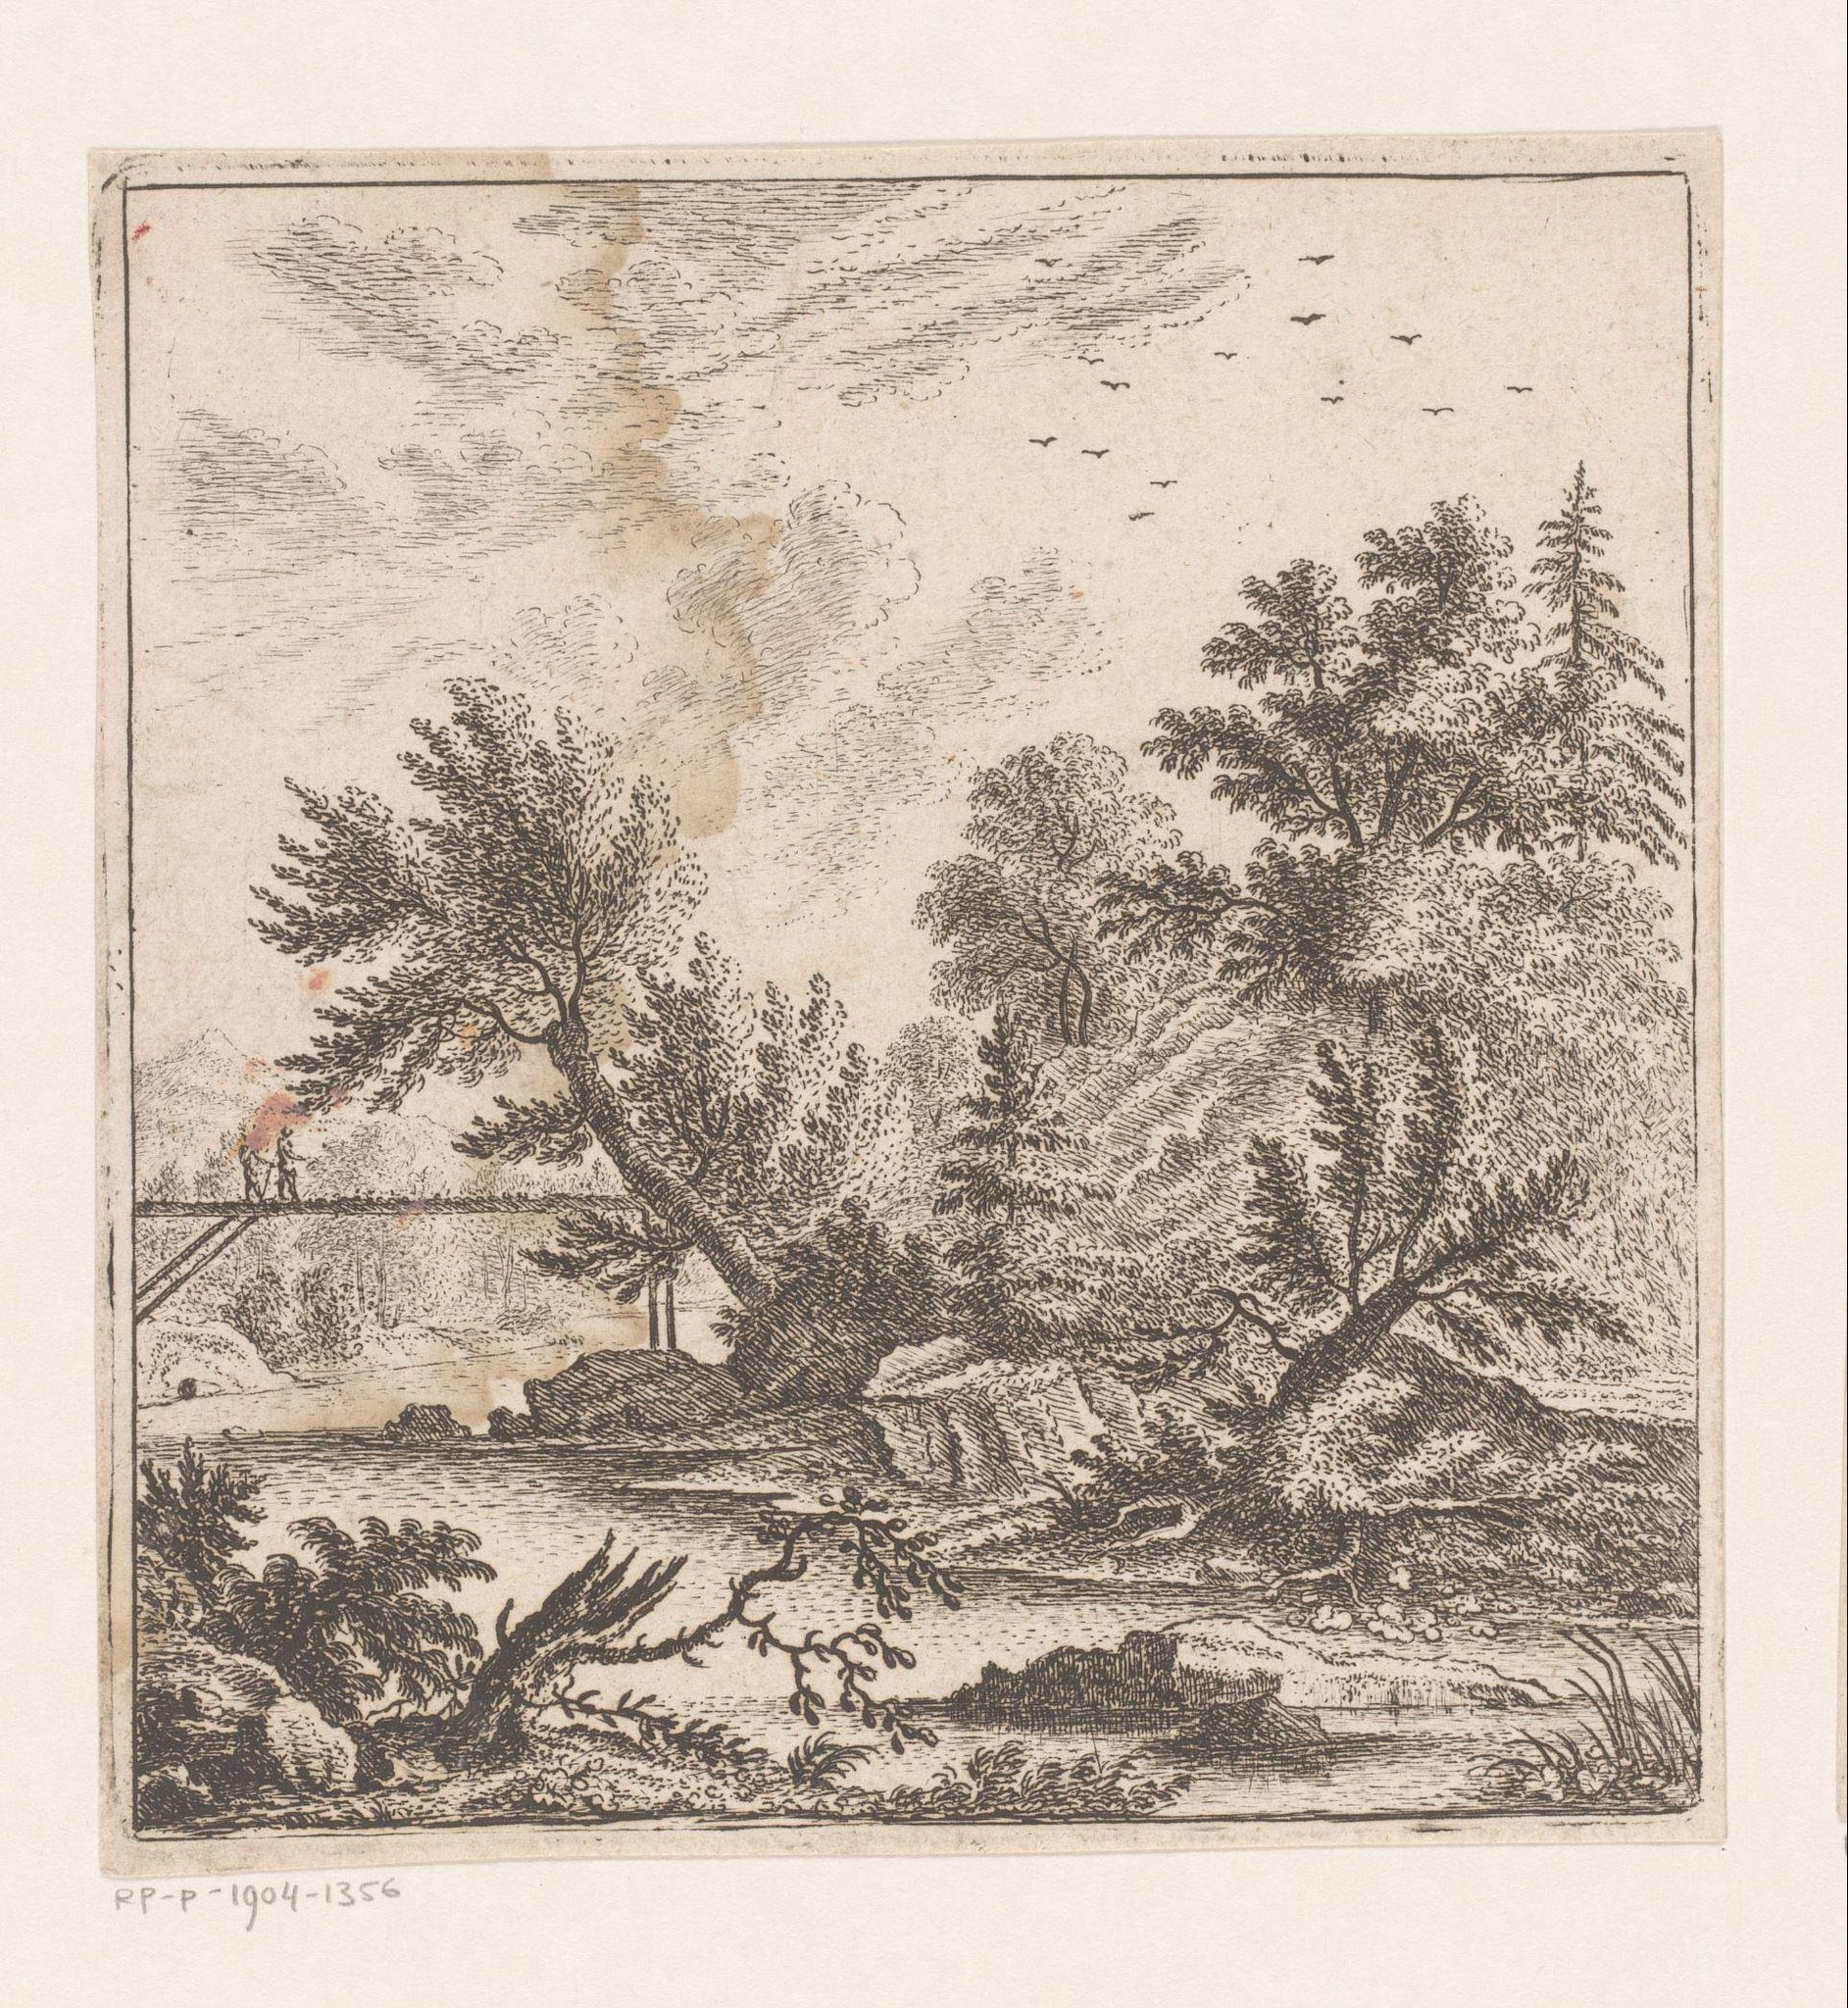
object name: print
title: Bosrijk landschap met twee figuren op een brug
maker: johann caspar ulinger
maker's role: painter, print maker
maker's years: 1703-1768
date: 1713-1768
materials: paper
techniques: etching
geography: switzerland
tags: landscape with bridge, viaduct or aqueduct, landscapes with waters, waterscapes, seascapes (in the temperate zone), forest, wood, 'en route', traveller under way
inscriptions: collector's mark: Lugt 2228